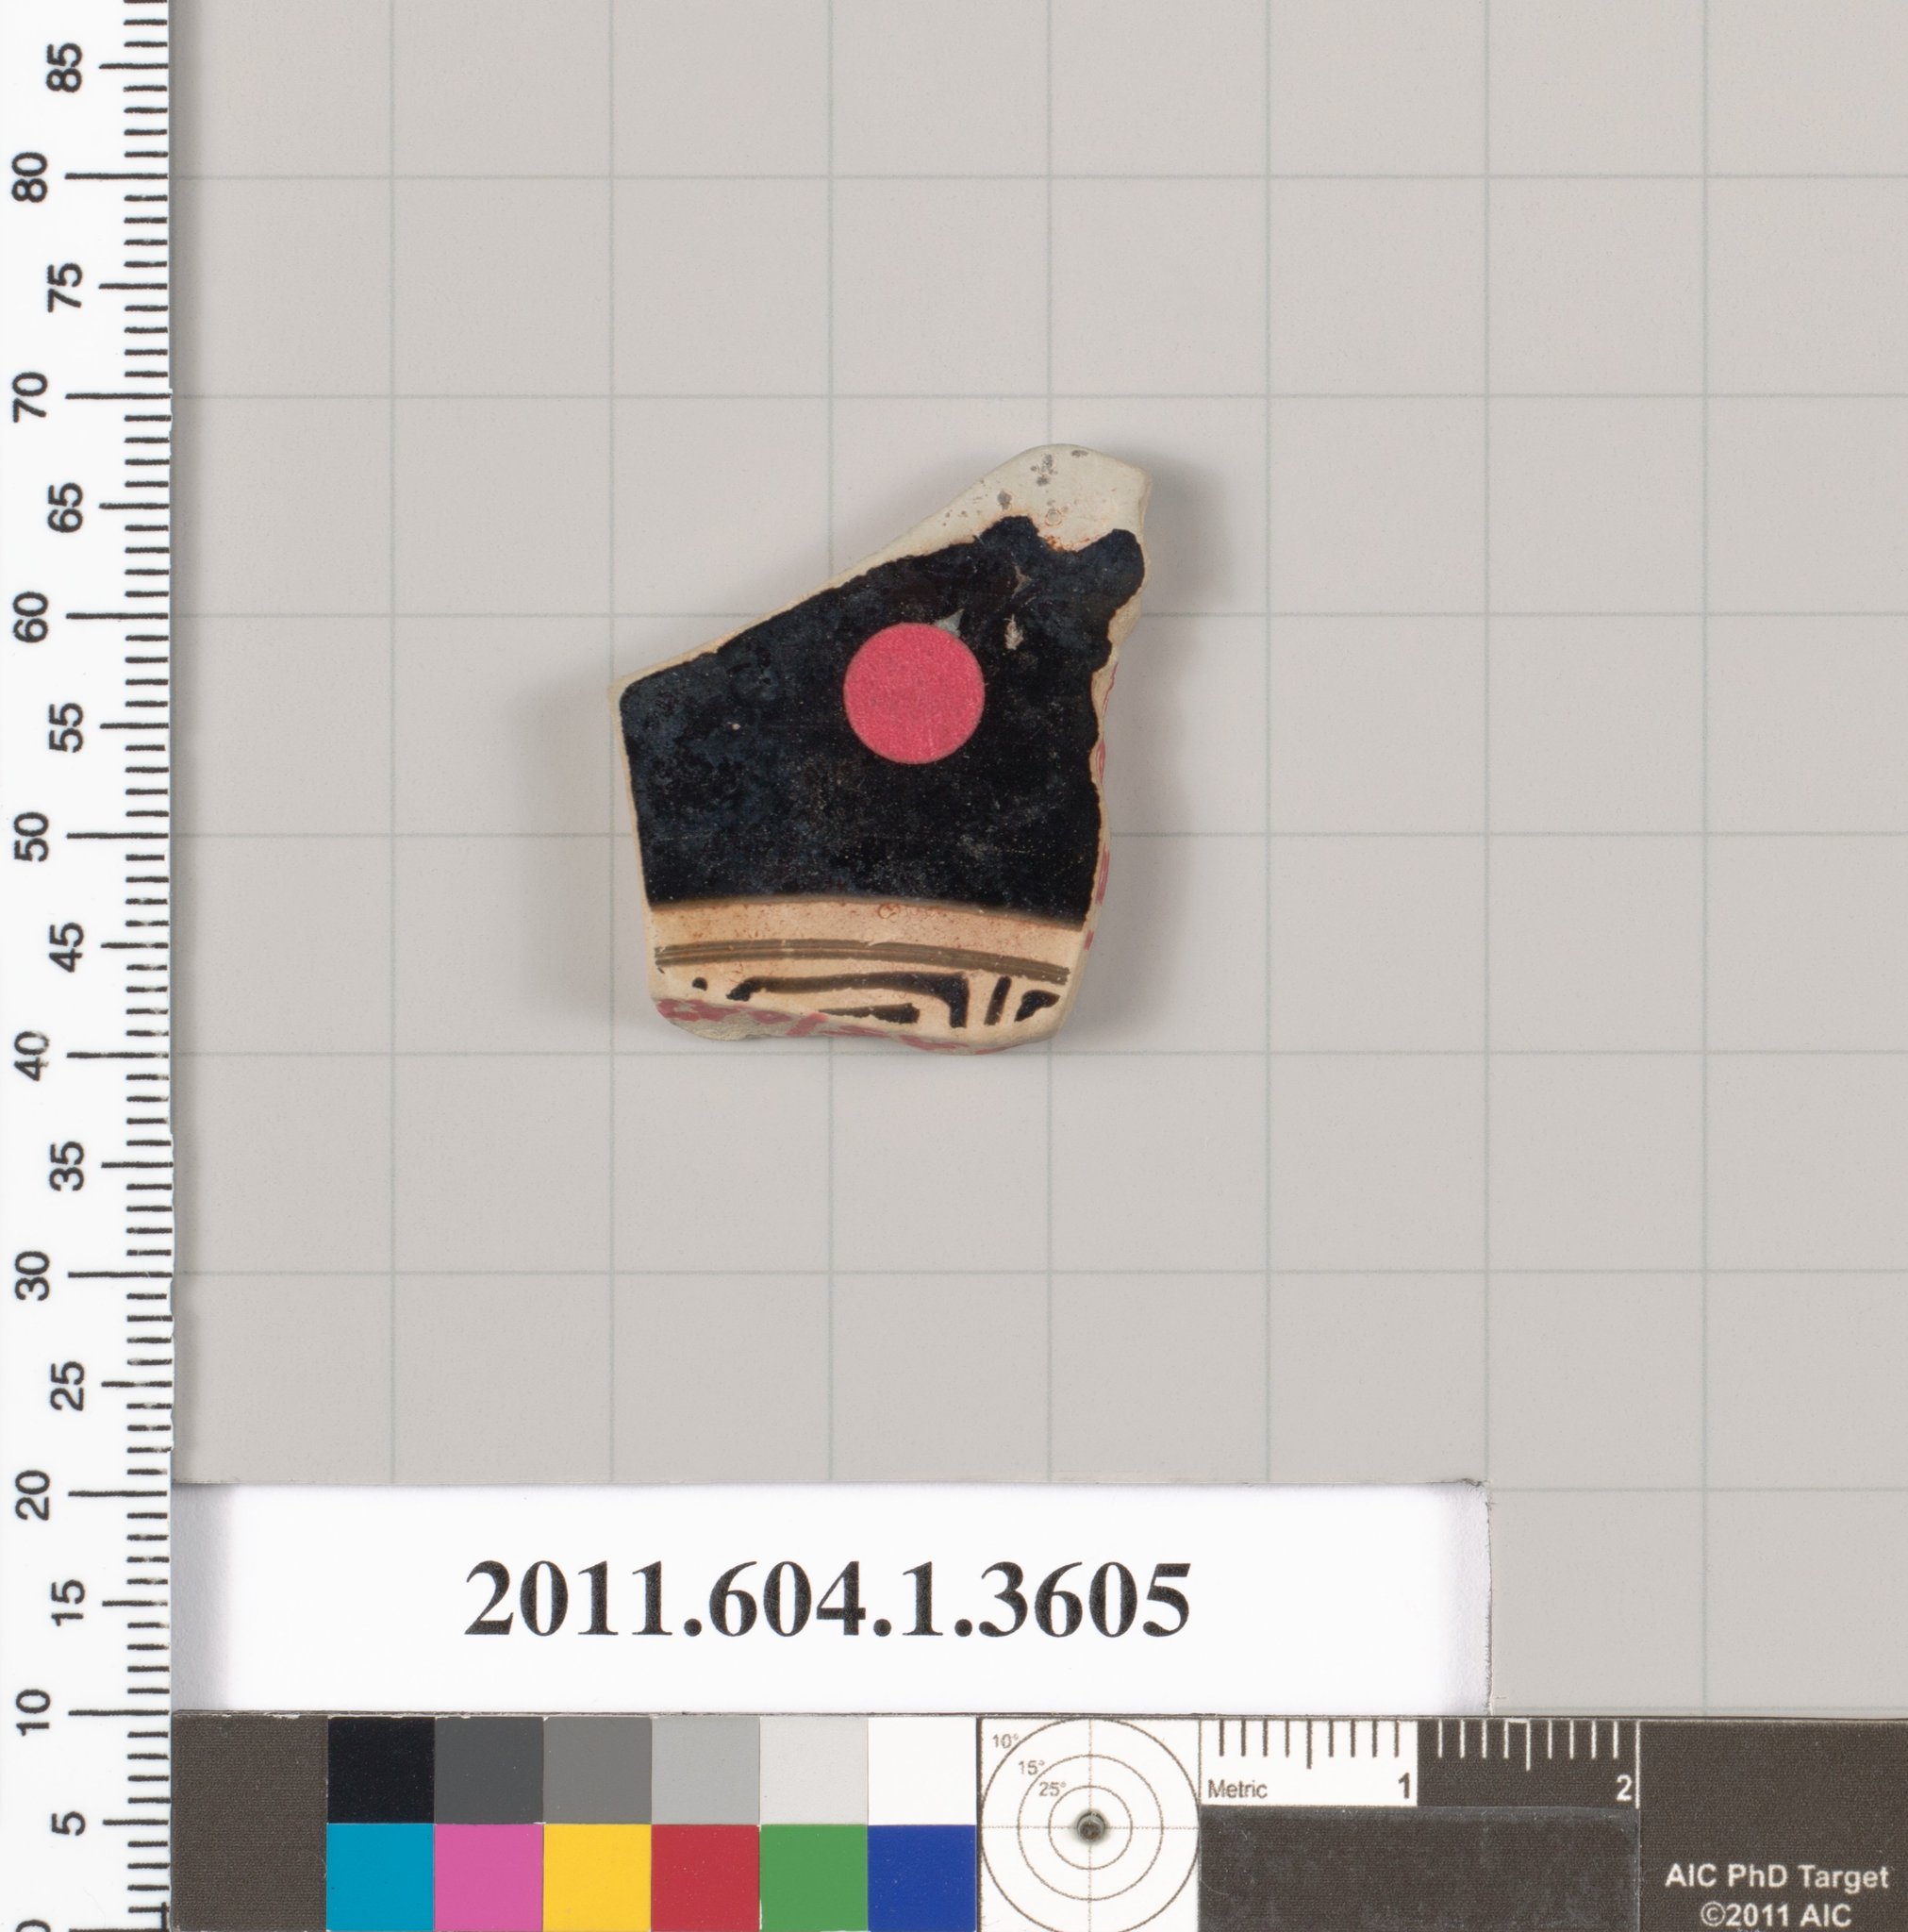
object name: kylix fragment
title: Terracotta fragment of a kylix (drinking cup)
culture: greek, attic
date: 500-470 BCE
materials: terracotta